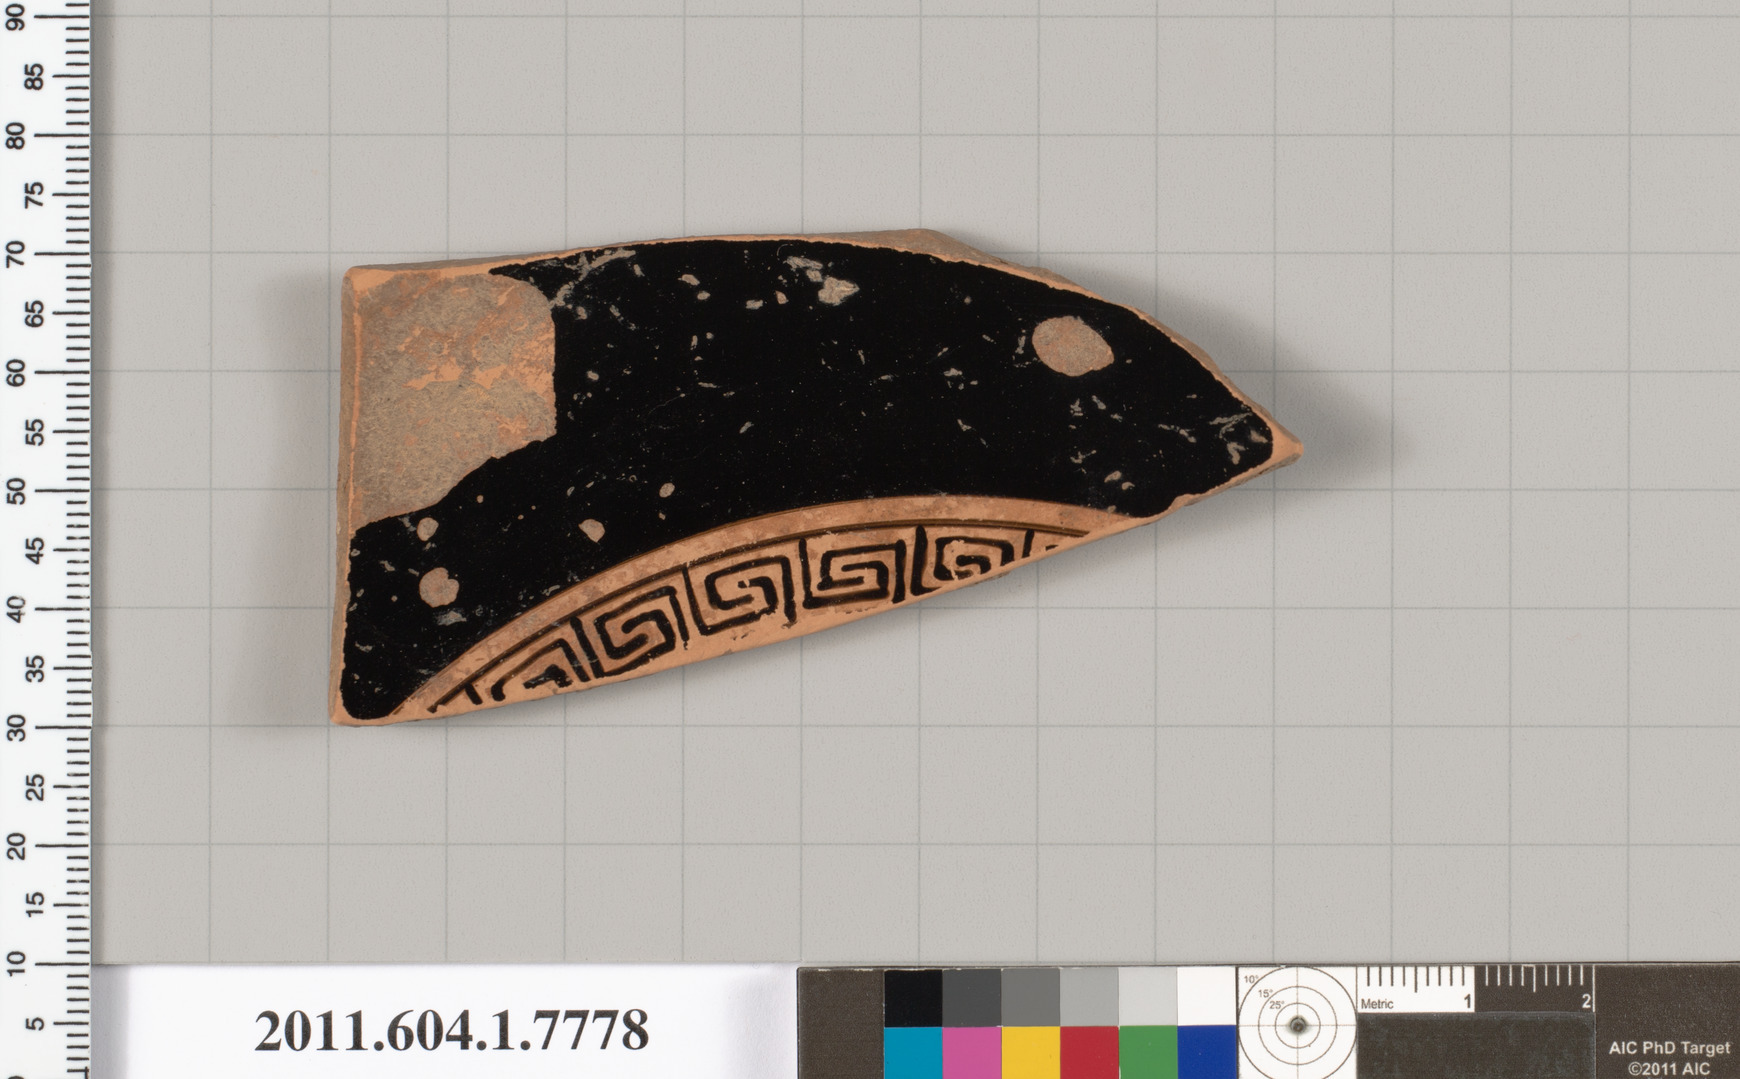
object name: kylix fragment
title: Terracotta fragment of a kylix (drinking cup)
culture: greek, attic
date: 460-450 BCE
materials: terracotta